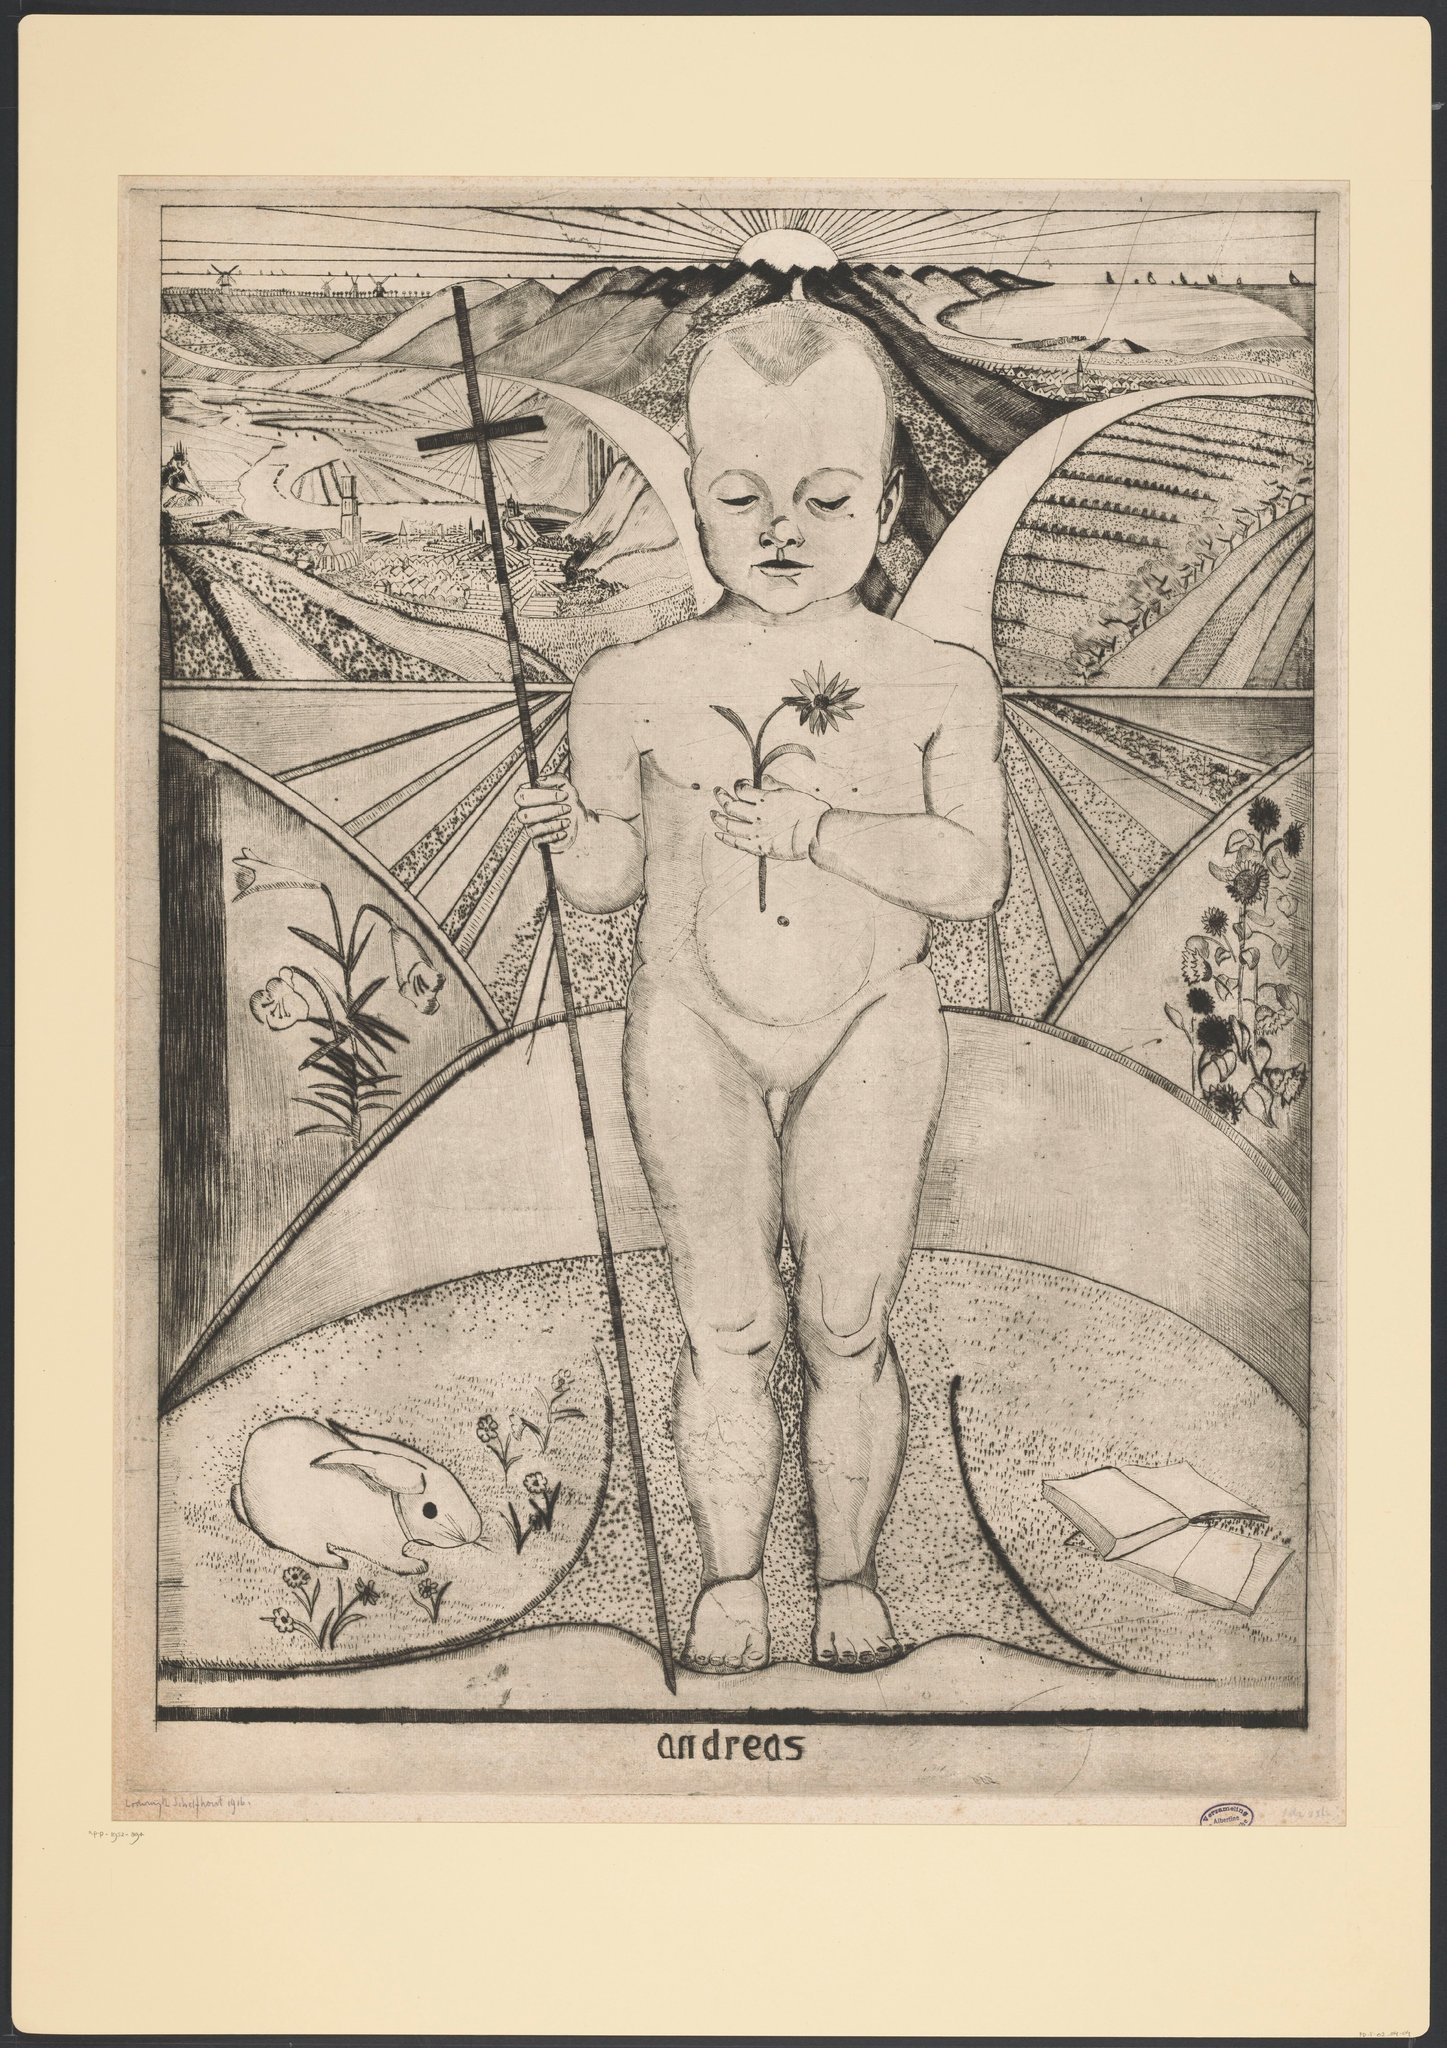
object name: print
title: Andreas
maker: lodewijk schelfhout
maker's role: draughtsman, print maker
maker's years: 1881-1943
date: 1916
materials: paper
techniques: drypoint, intaglio, retroussage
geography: netherlands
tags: landscapes, the apostle andrew; possible attributes: book, x-shaped cross, fish, fishing-net, rope, scroll, rodents: rabbit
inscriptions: collector's mark: Lugt 2228, collector's mark: Lugt 2760, collector's mark: Lugt 5i